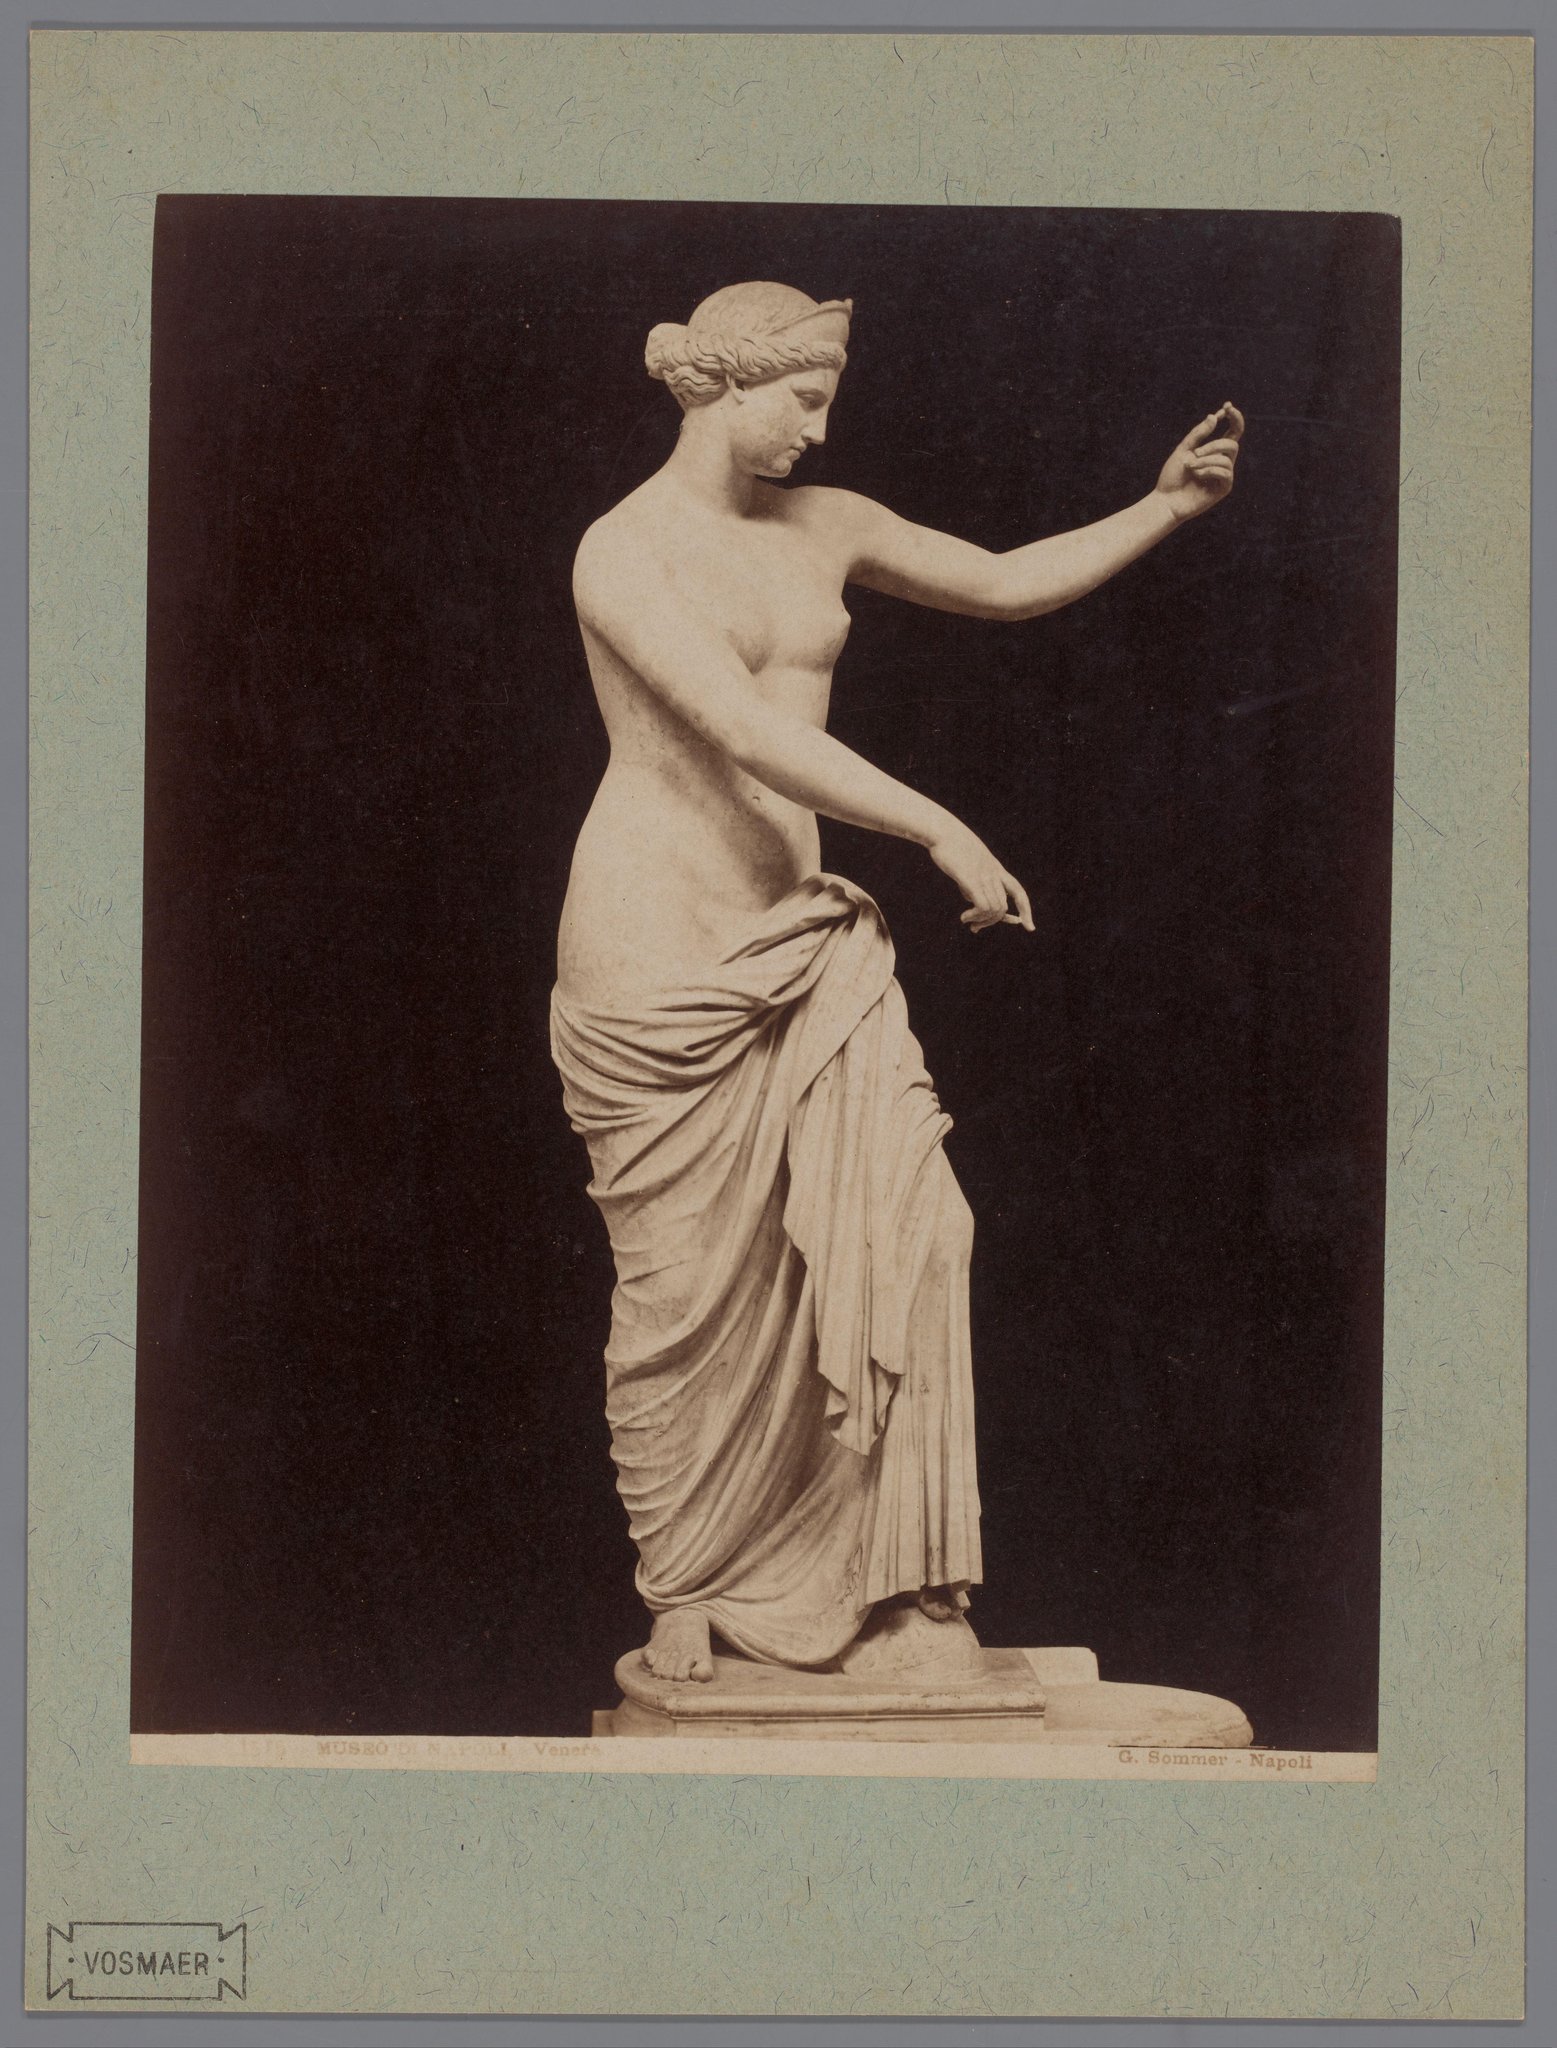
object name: photograph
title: Sculptuur van Venus in het Museo Nazionale te Napels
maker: giorgio sommer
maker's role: fotograaf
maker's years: 1834-1914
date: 1857-1914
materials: cardboard, paper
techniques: albumen print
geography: naples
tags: piece of sculpture, reproduction of a piece of sculpture, (story of) venus (aphrodite)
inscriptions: inscription: ‘11’, collector's mark: ‘VOSMAER’, inscription: ‘Venus/ Museo Nazionale - Napoli.’, number: ‘1515 [?]’